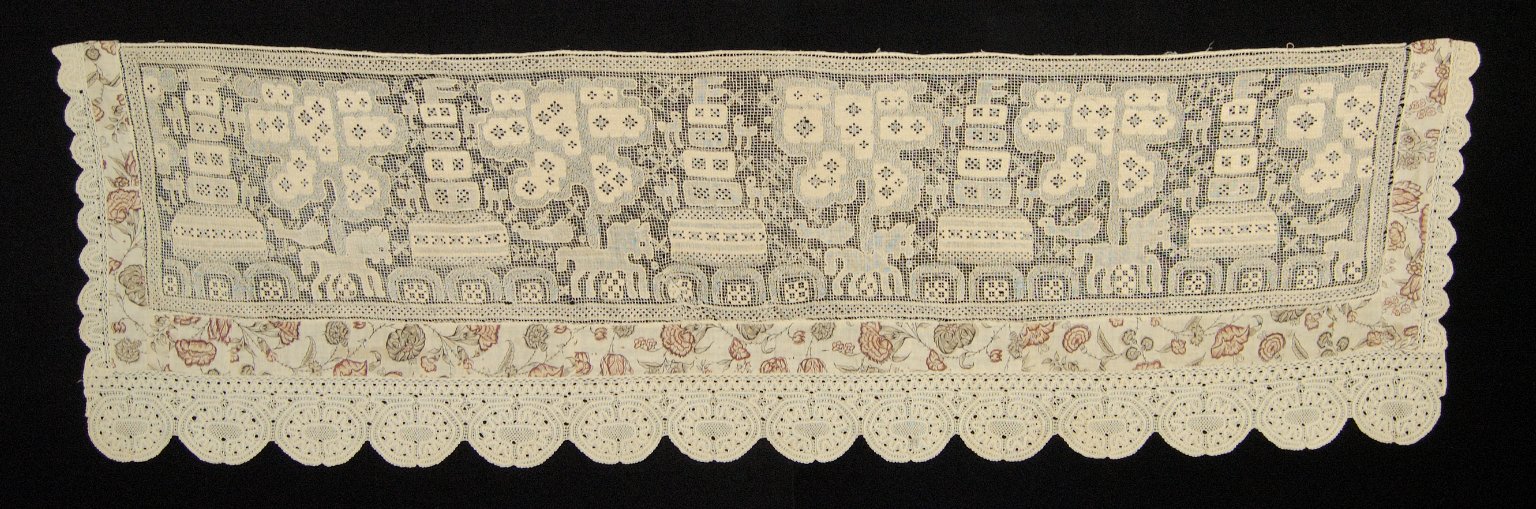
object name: border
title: Bed curtain border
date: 1800-1850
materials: linen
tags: horses,flowers